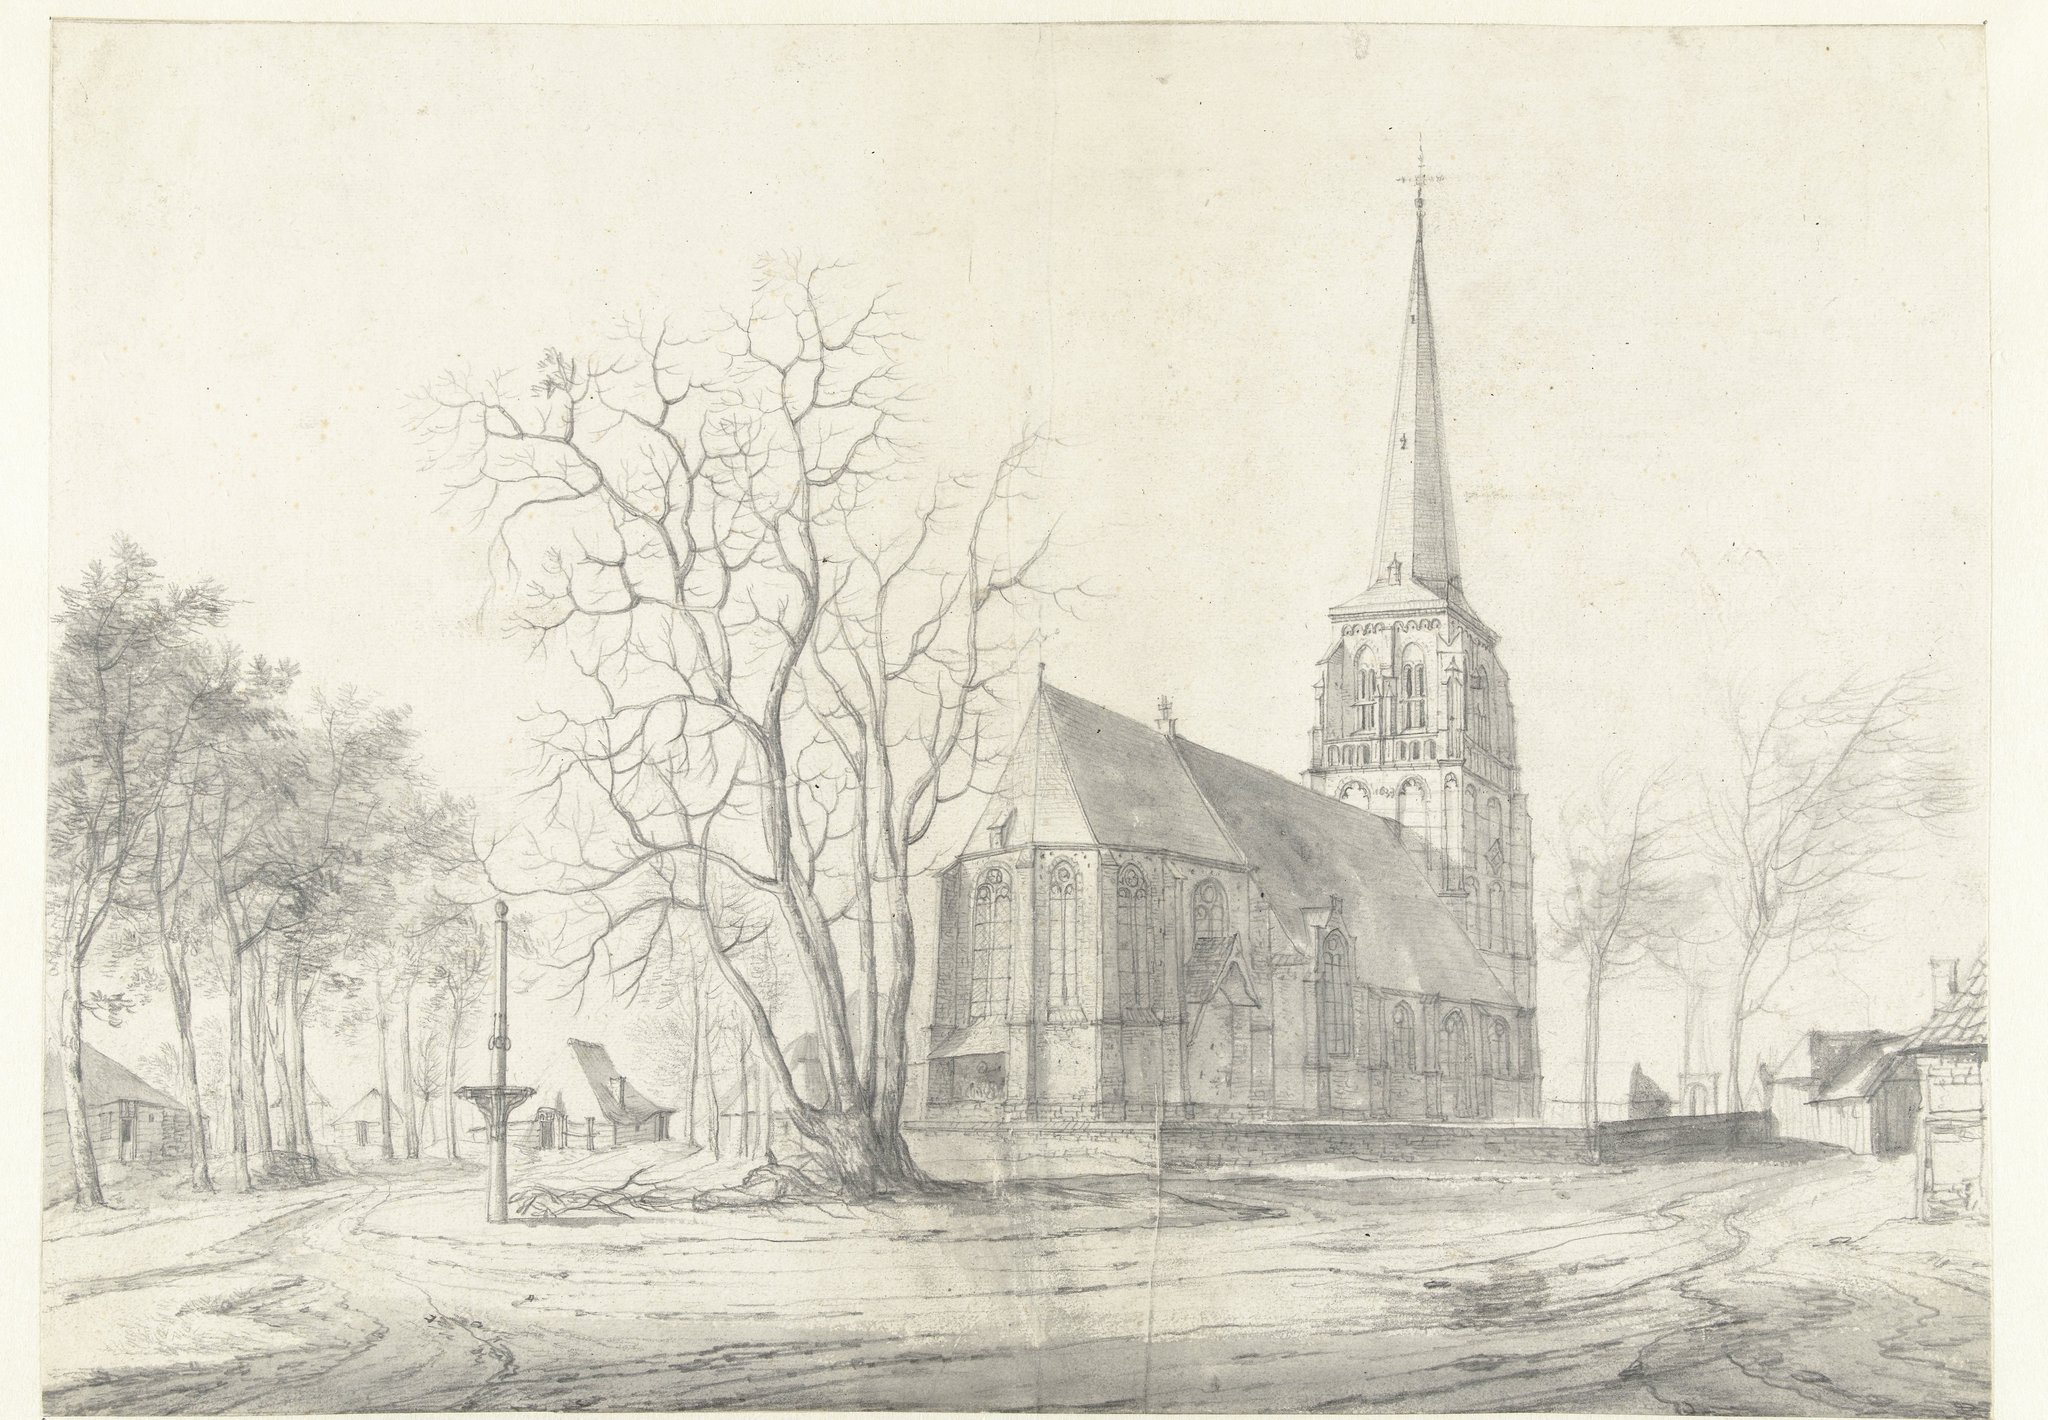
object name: drawing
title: Kerk van de H. Michaël te Sint Michielsgestel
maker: jan abrahamsz. beerstraten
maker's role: draughtsman, painter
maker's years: 1622-1666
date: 1637-1700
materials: graphite, paper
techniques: brush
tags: church (exterior)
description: Kerk van de H. Michael te Sint Michielsgestel (Noord-Brabant) uit het noordoosten.